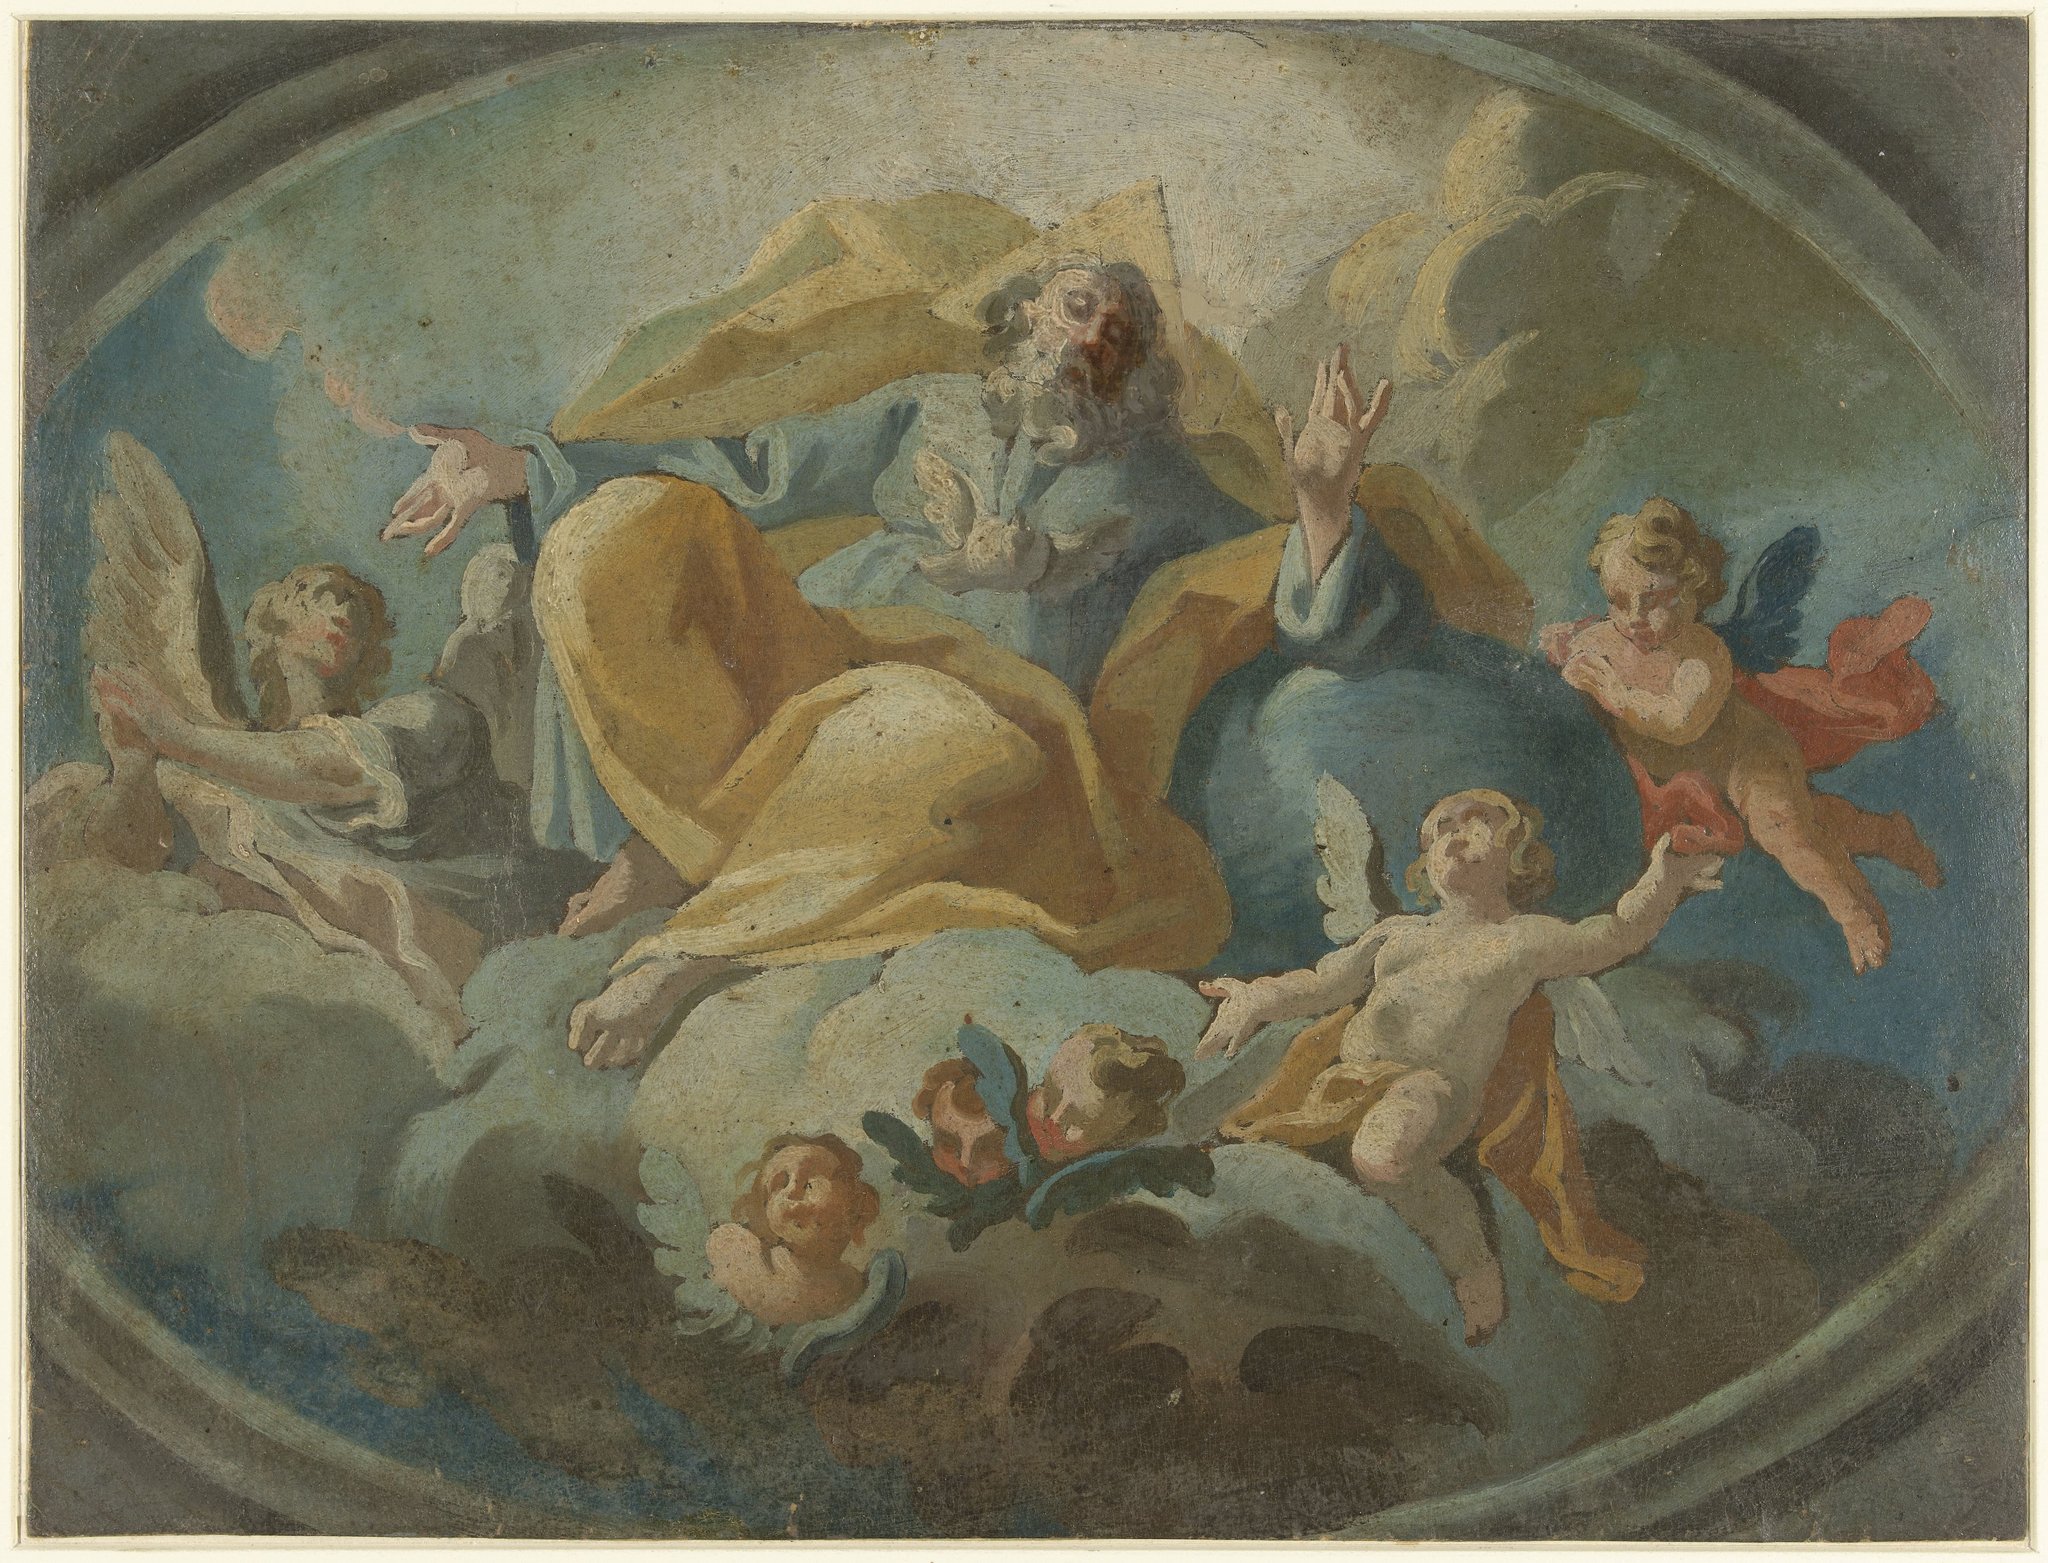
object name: drawing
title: God met engelen in de wolken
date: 1718-1787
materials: oil, paper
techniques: brush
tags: god the father represented as human being, usually with crown or tiara or sceptre and/or globe (+ angels floating in the air)